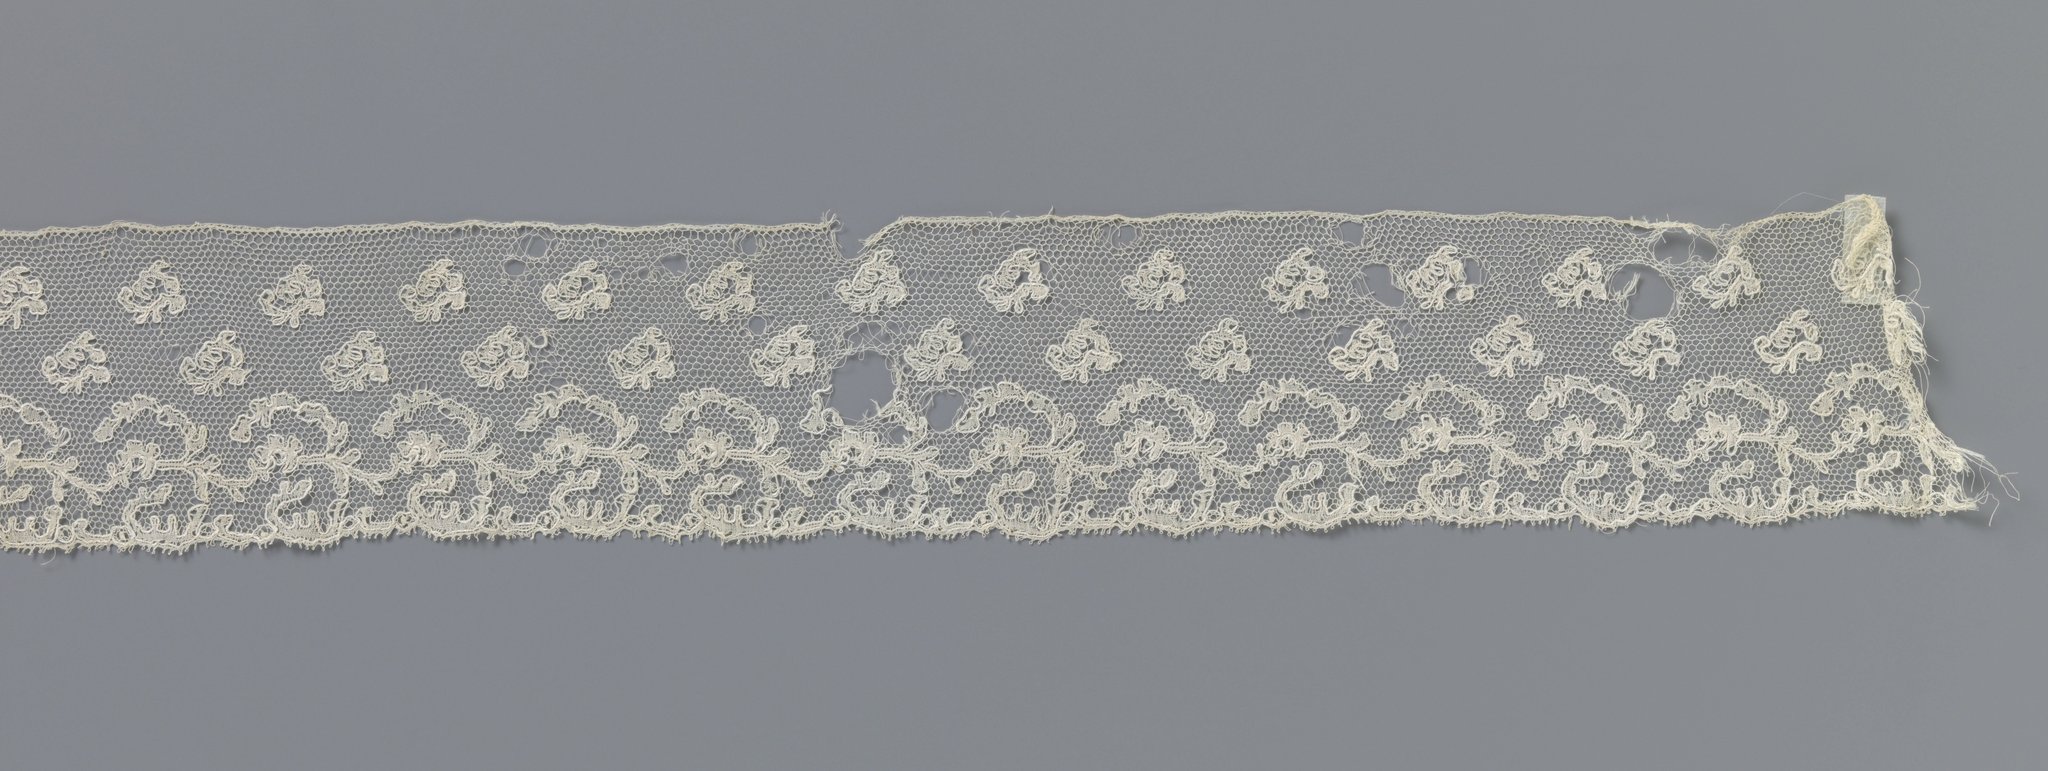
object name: strip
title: Strook kloskant met grillige strooimotieven en rank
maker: Anonymous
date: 1800-1899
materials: linen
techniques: lace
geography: southern netherlands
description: Strook naturelkleurige kloskant: Rijselse kant. Onder twee rijen grillige motieven loopt een golvende rank, met een rozetbloempje aan elke golftop. Over elk rozetbloempje loopt een grillig boogje, gevormd door een langwerpig blad. Vergelijkbare omgekeerde boogjes, afgewisseld door ovaaltjes, vormen de flauwe schulpen langs de onderzijde van de strook. De motieven zijn met elkaar verbonden door een fijne traliegrond, een tulegrond. Het spaarzame volwerk is gemaakt in linnenslag, met dikkere en glimmende contourdraden. In de ovaaltjes is afwisselend een moesje geplaatst, gemaakt in vormslag. De boven- en onderzijde van de strook zijn recht afgewerkt, waarbij de onderzijde is voorzien van picots.